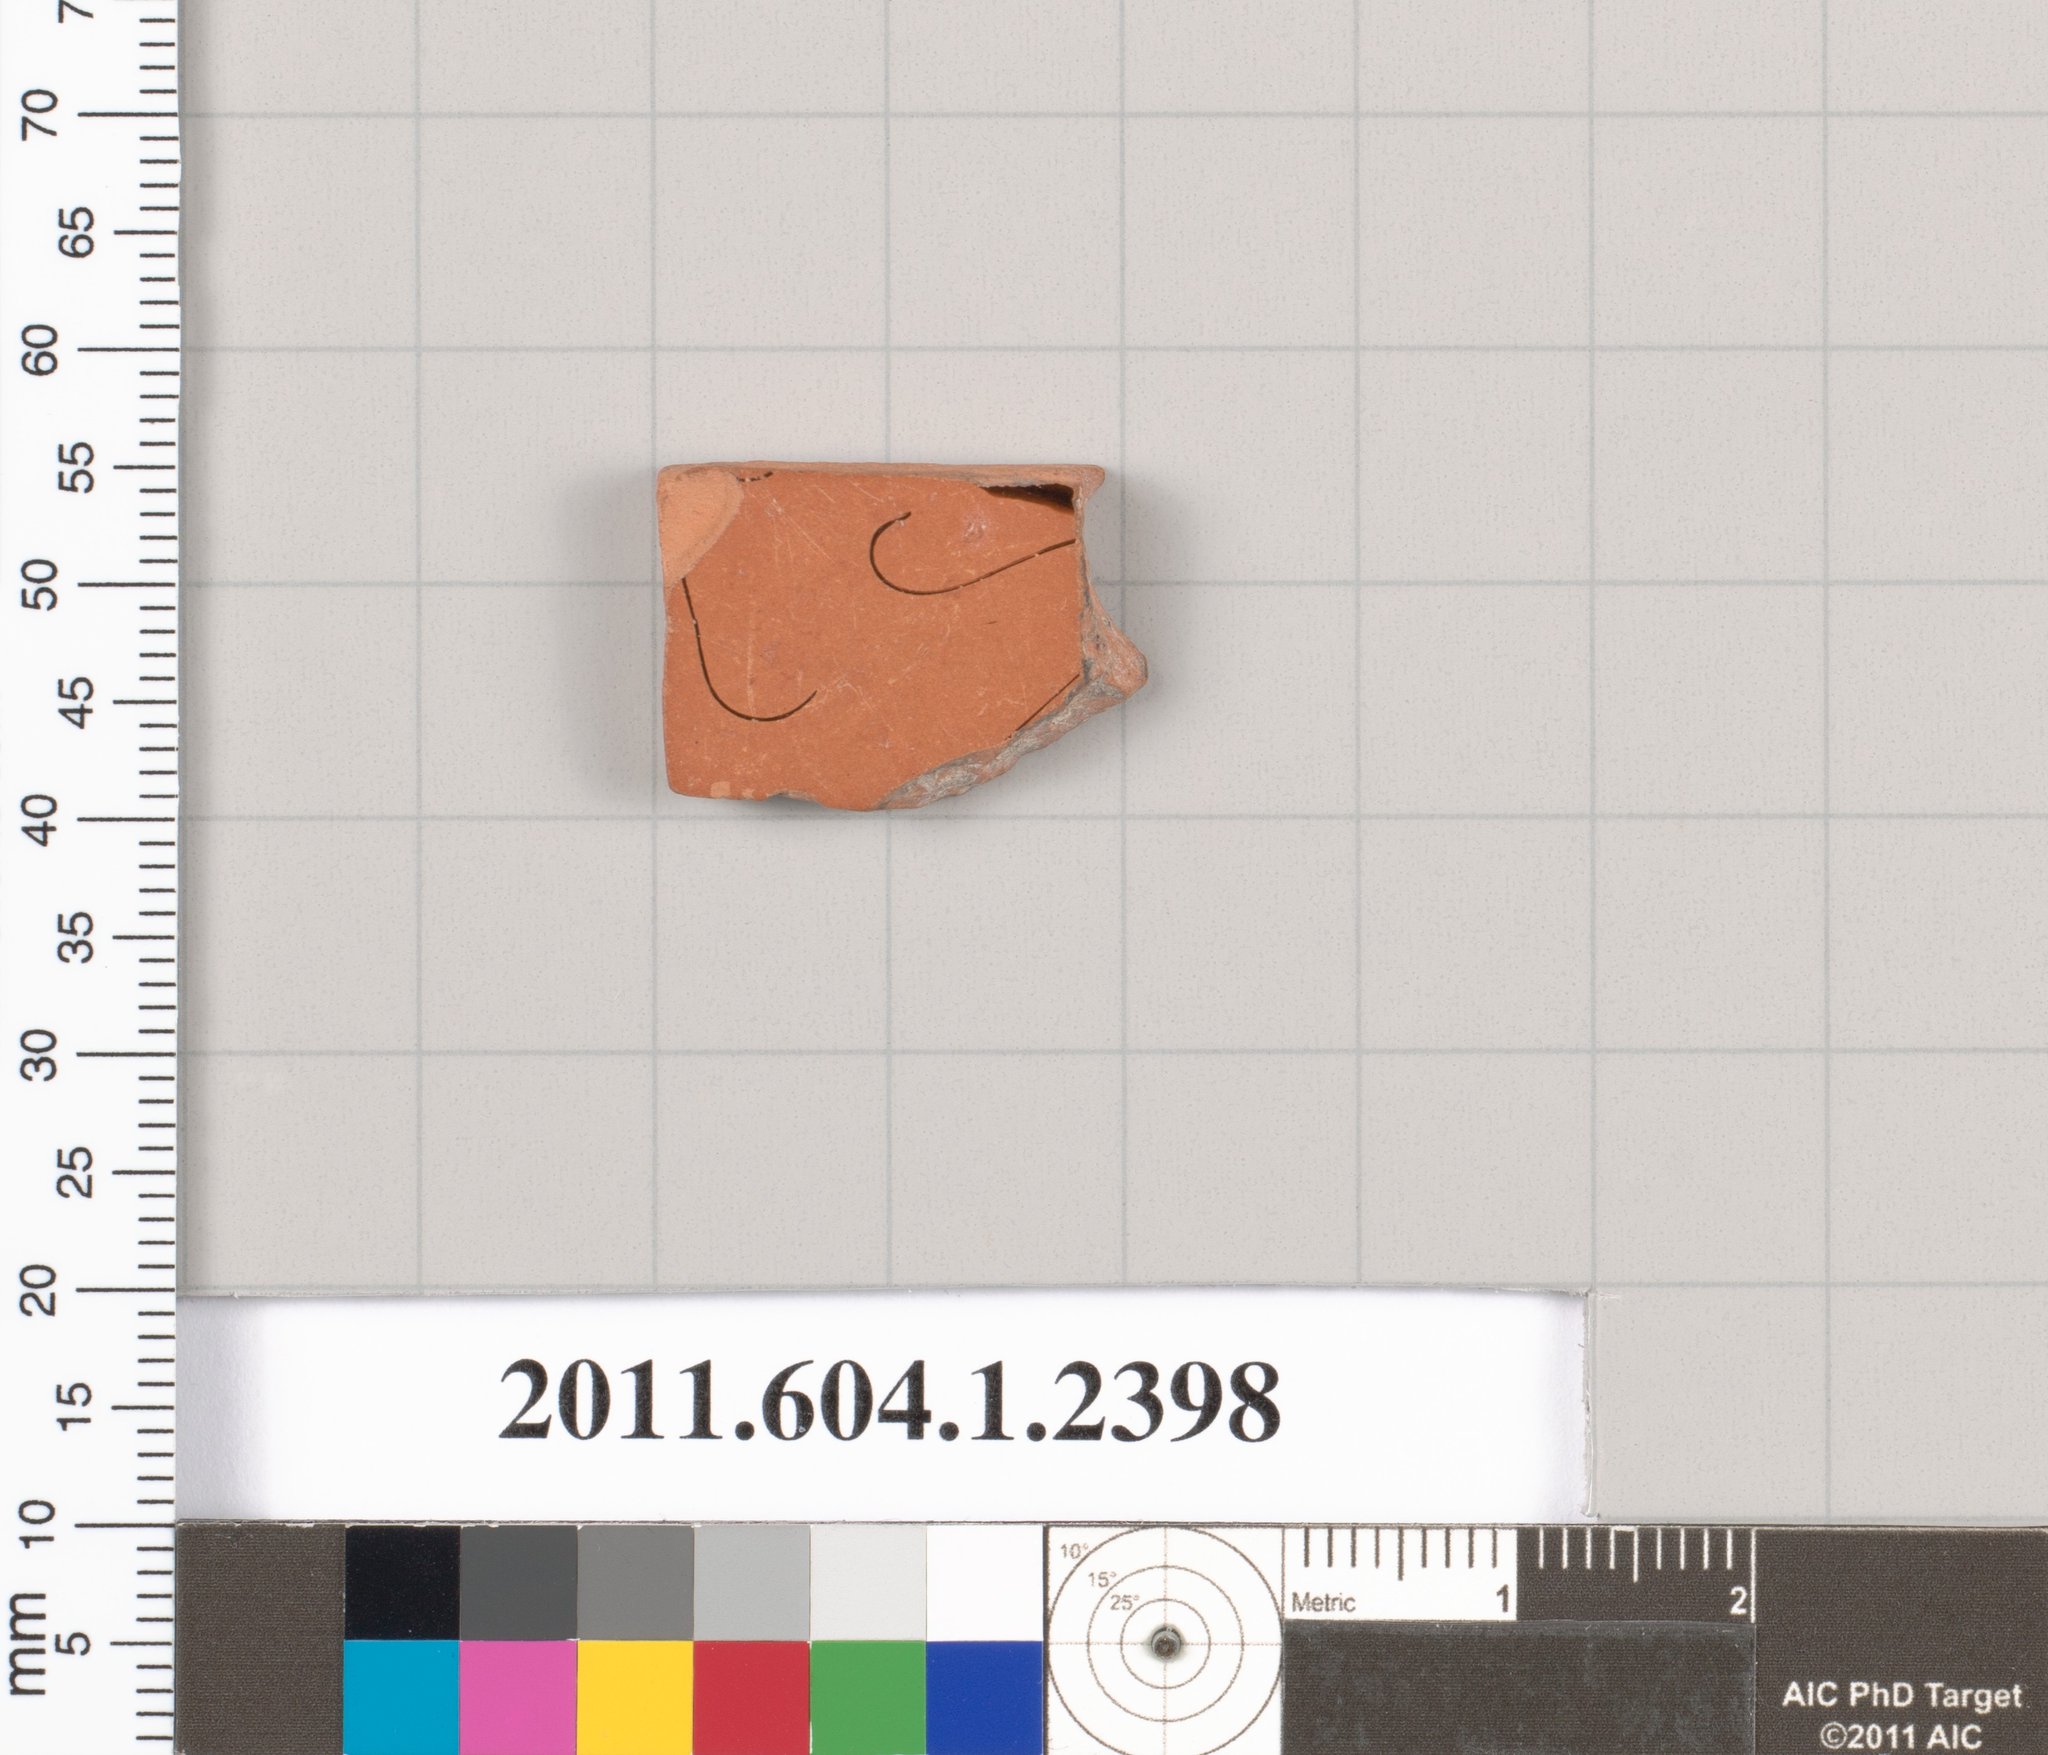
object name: kylix fragment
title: Terracotta fragment of a kylix (drinking cup)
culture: greek, attic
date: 475-451 BCE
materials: terracotta